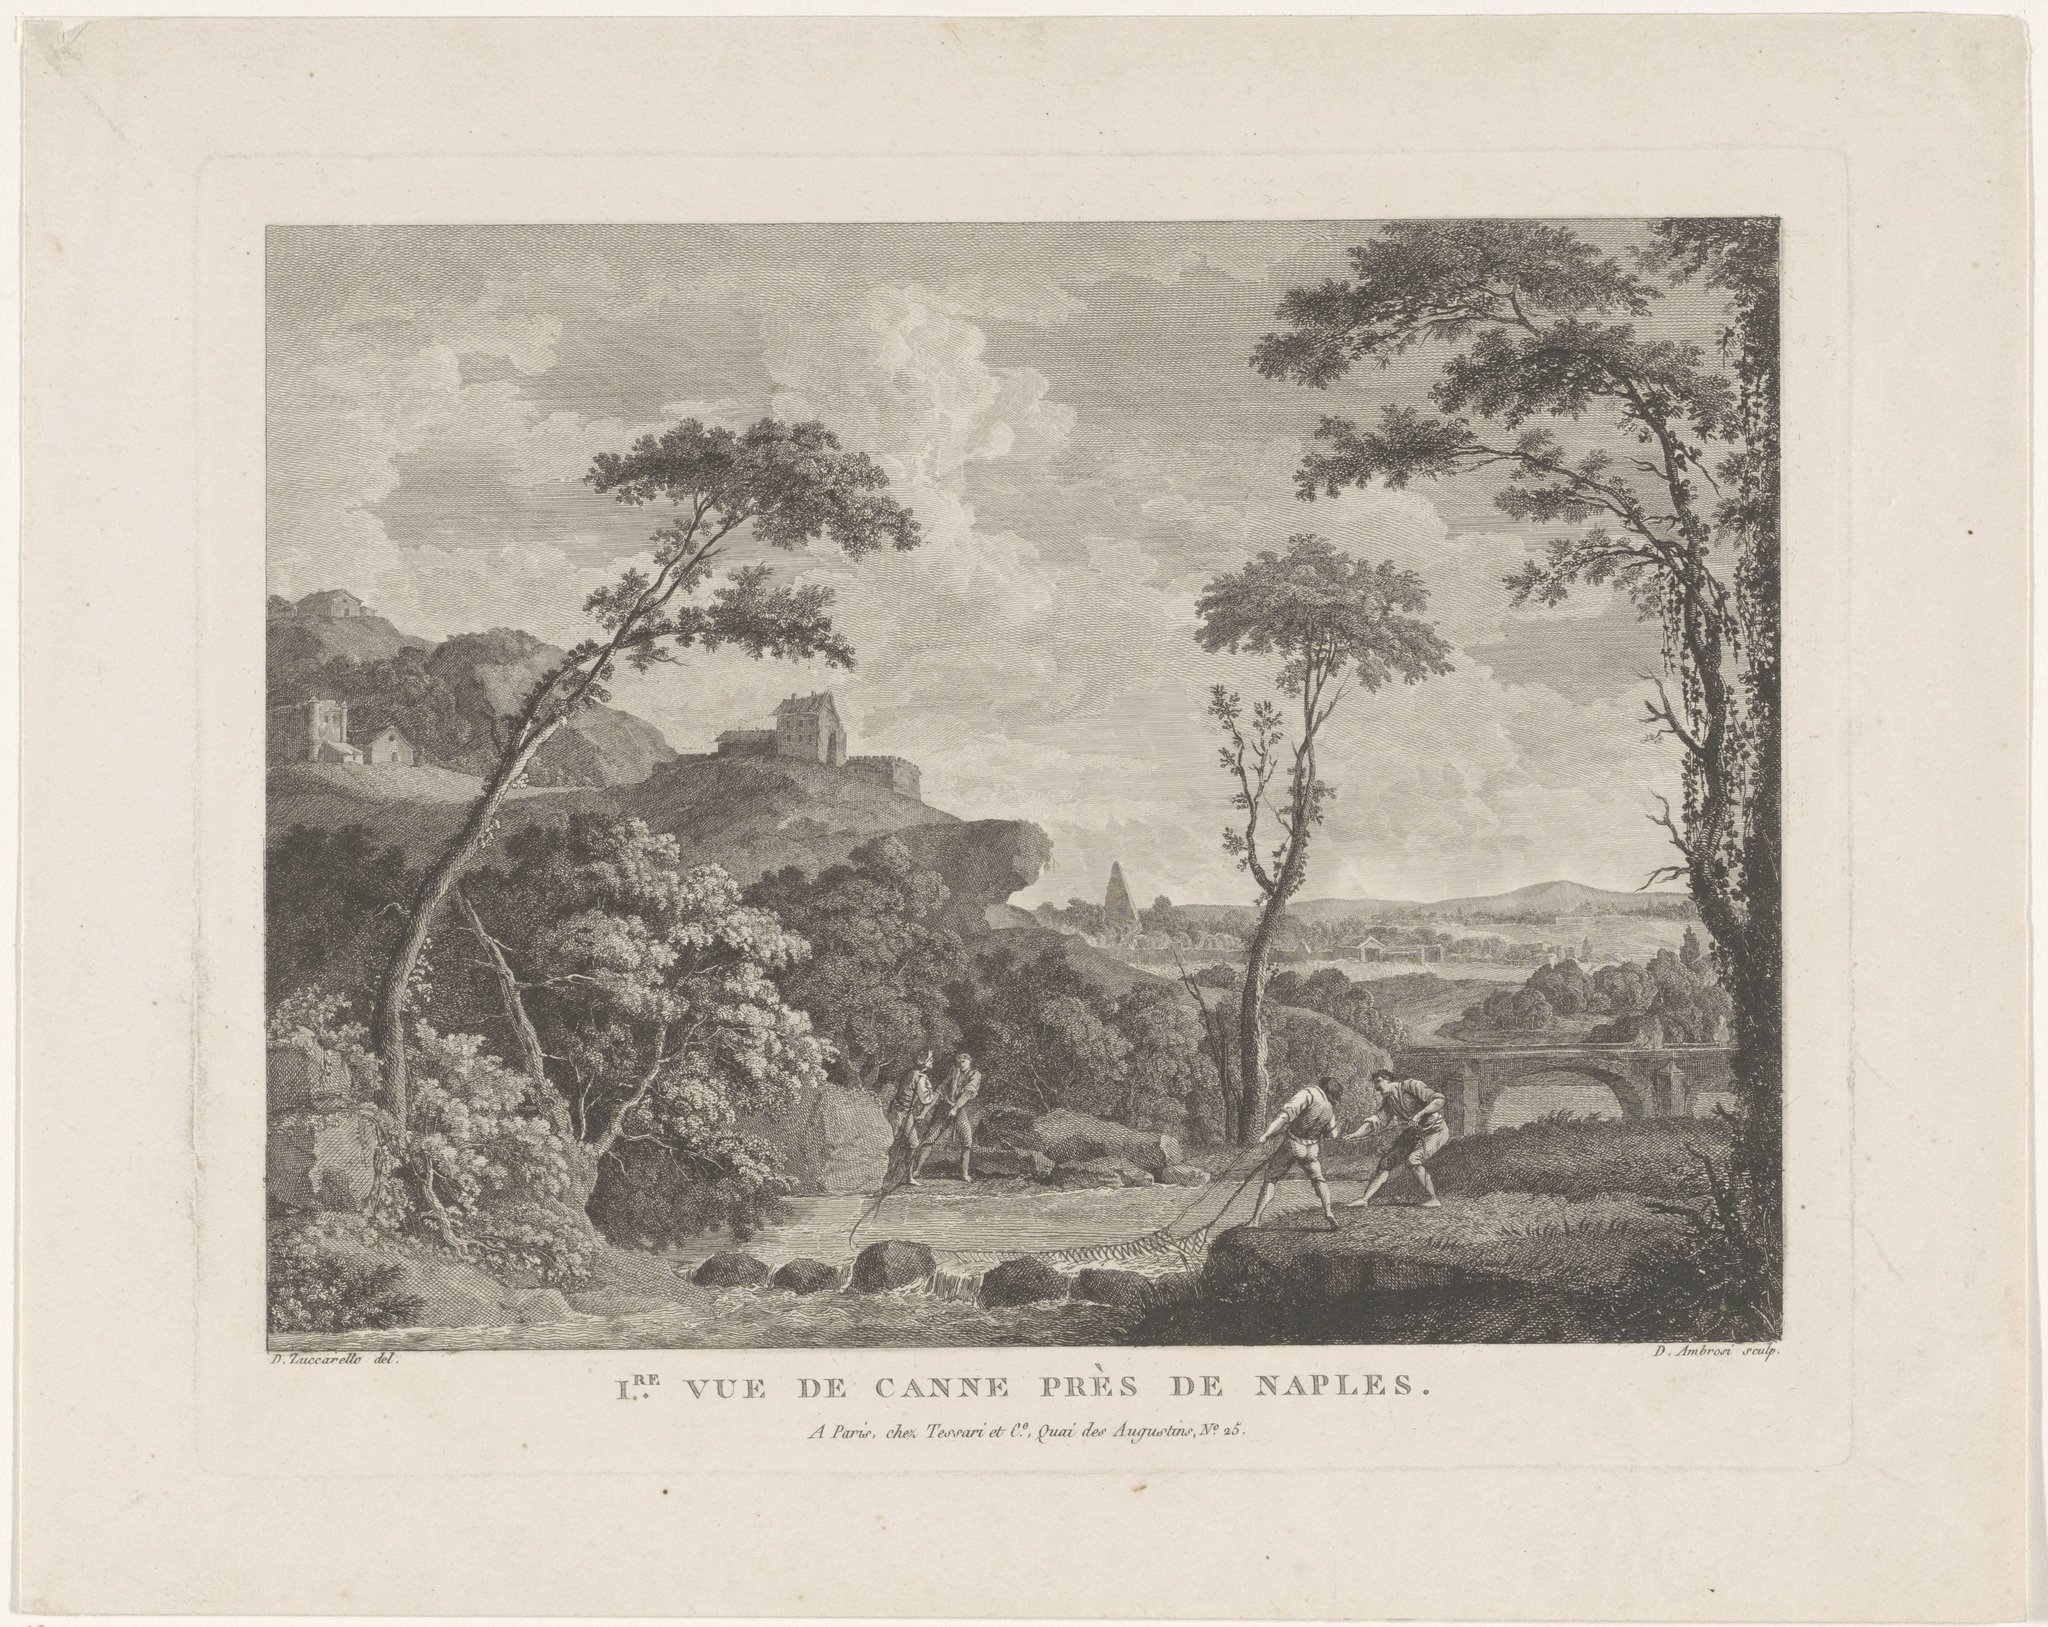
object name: print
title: Landschap rond Napels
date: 1700-1799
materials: paper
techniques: engraving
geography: italy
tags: city-view, and landscape with man-made constructions, naples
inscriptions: collector's mark: Lugt 2228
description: Landschap rond Napels. Vier mannen vissen met een groot net in de beek. In de ondermarge de titel in het Frans.